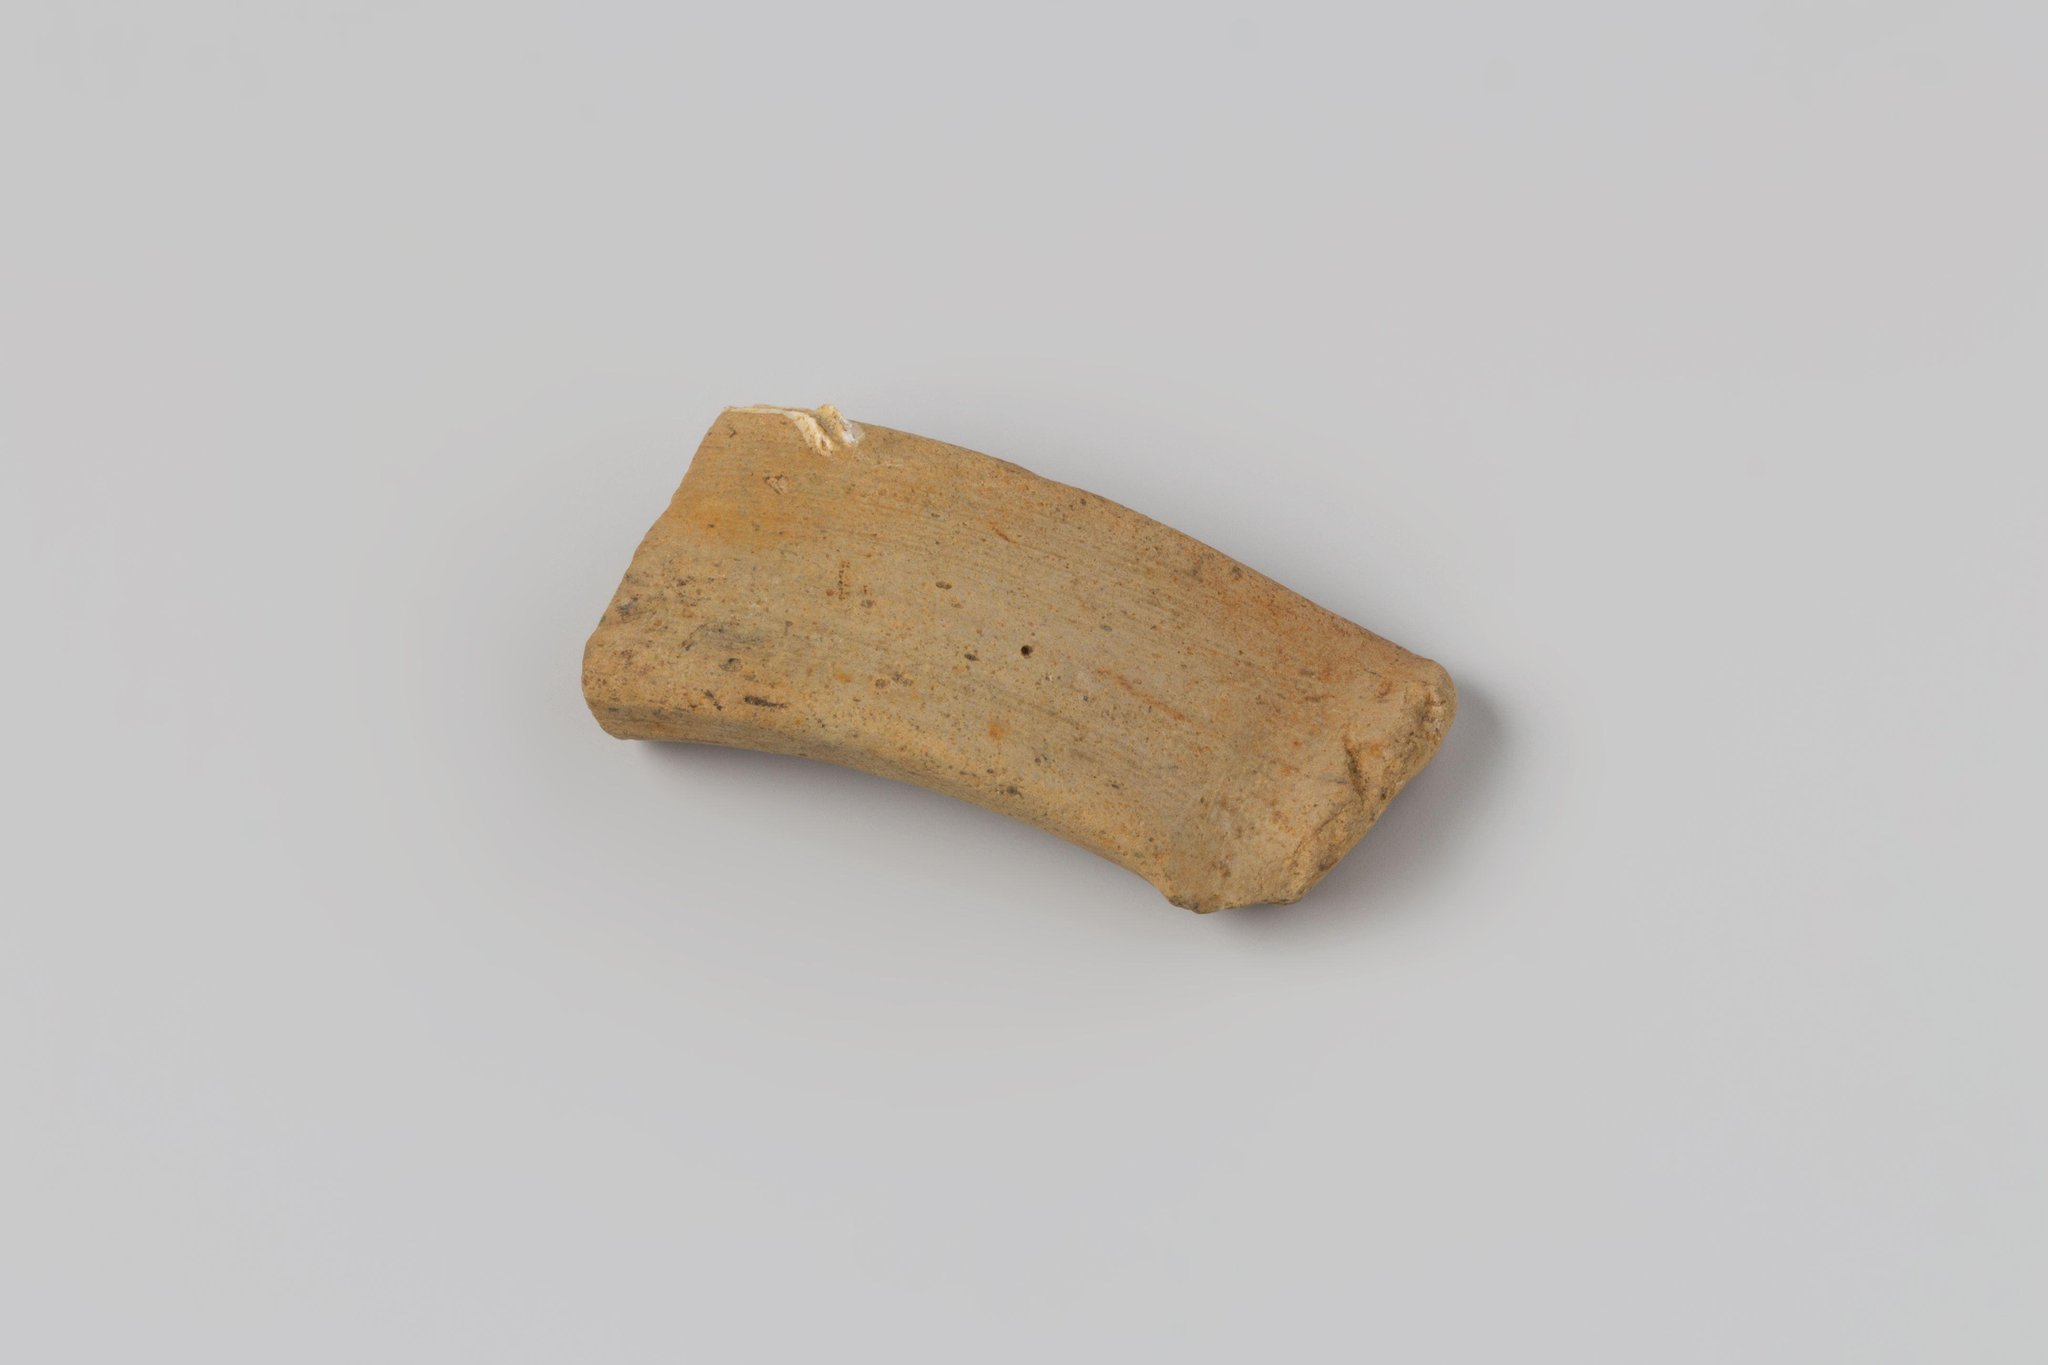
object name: sherd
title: oor van een pot uit het wrak van de Oost-Indiëvaarder Hollandia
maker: Anonymous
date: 1700-1743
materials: stoneware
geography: westerwald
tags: verenigde oostindische compagnie, hollandia (schip), annet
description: Stoneware, Rhenish, Westerwald, handle; fragm, flat in section, slightly curved, flat surface.